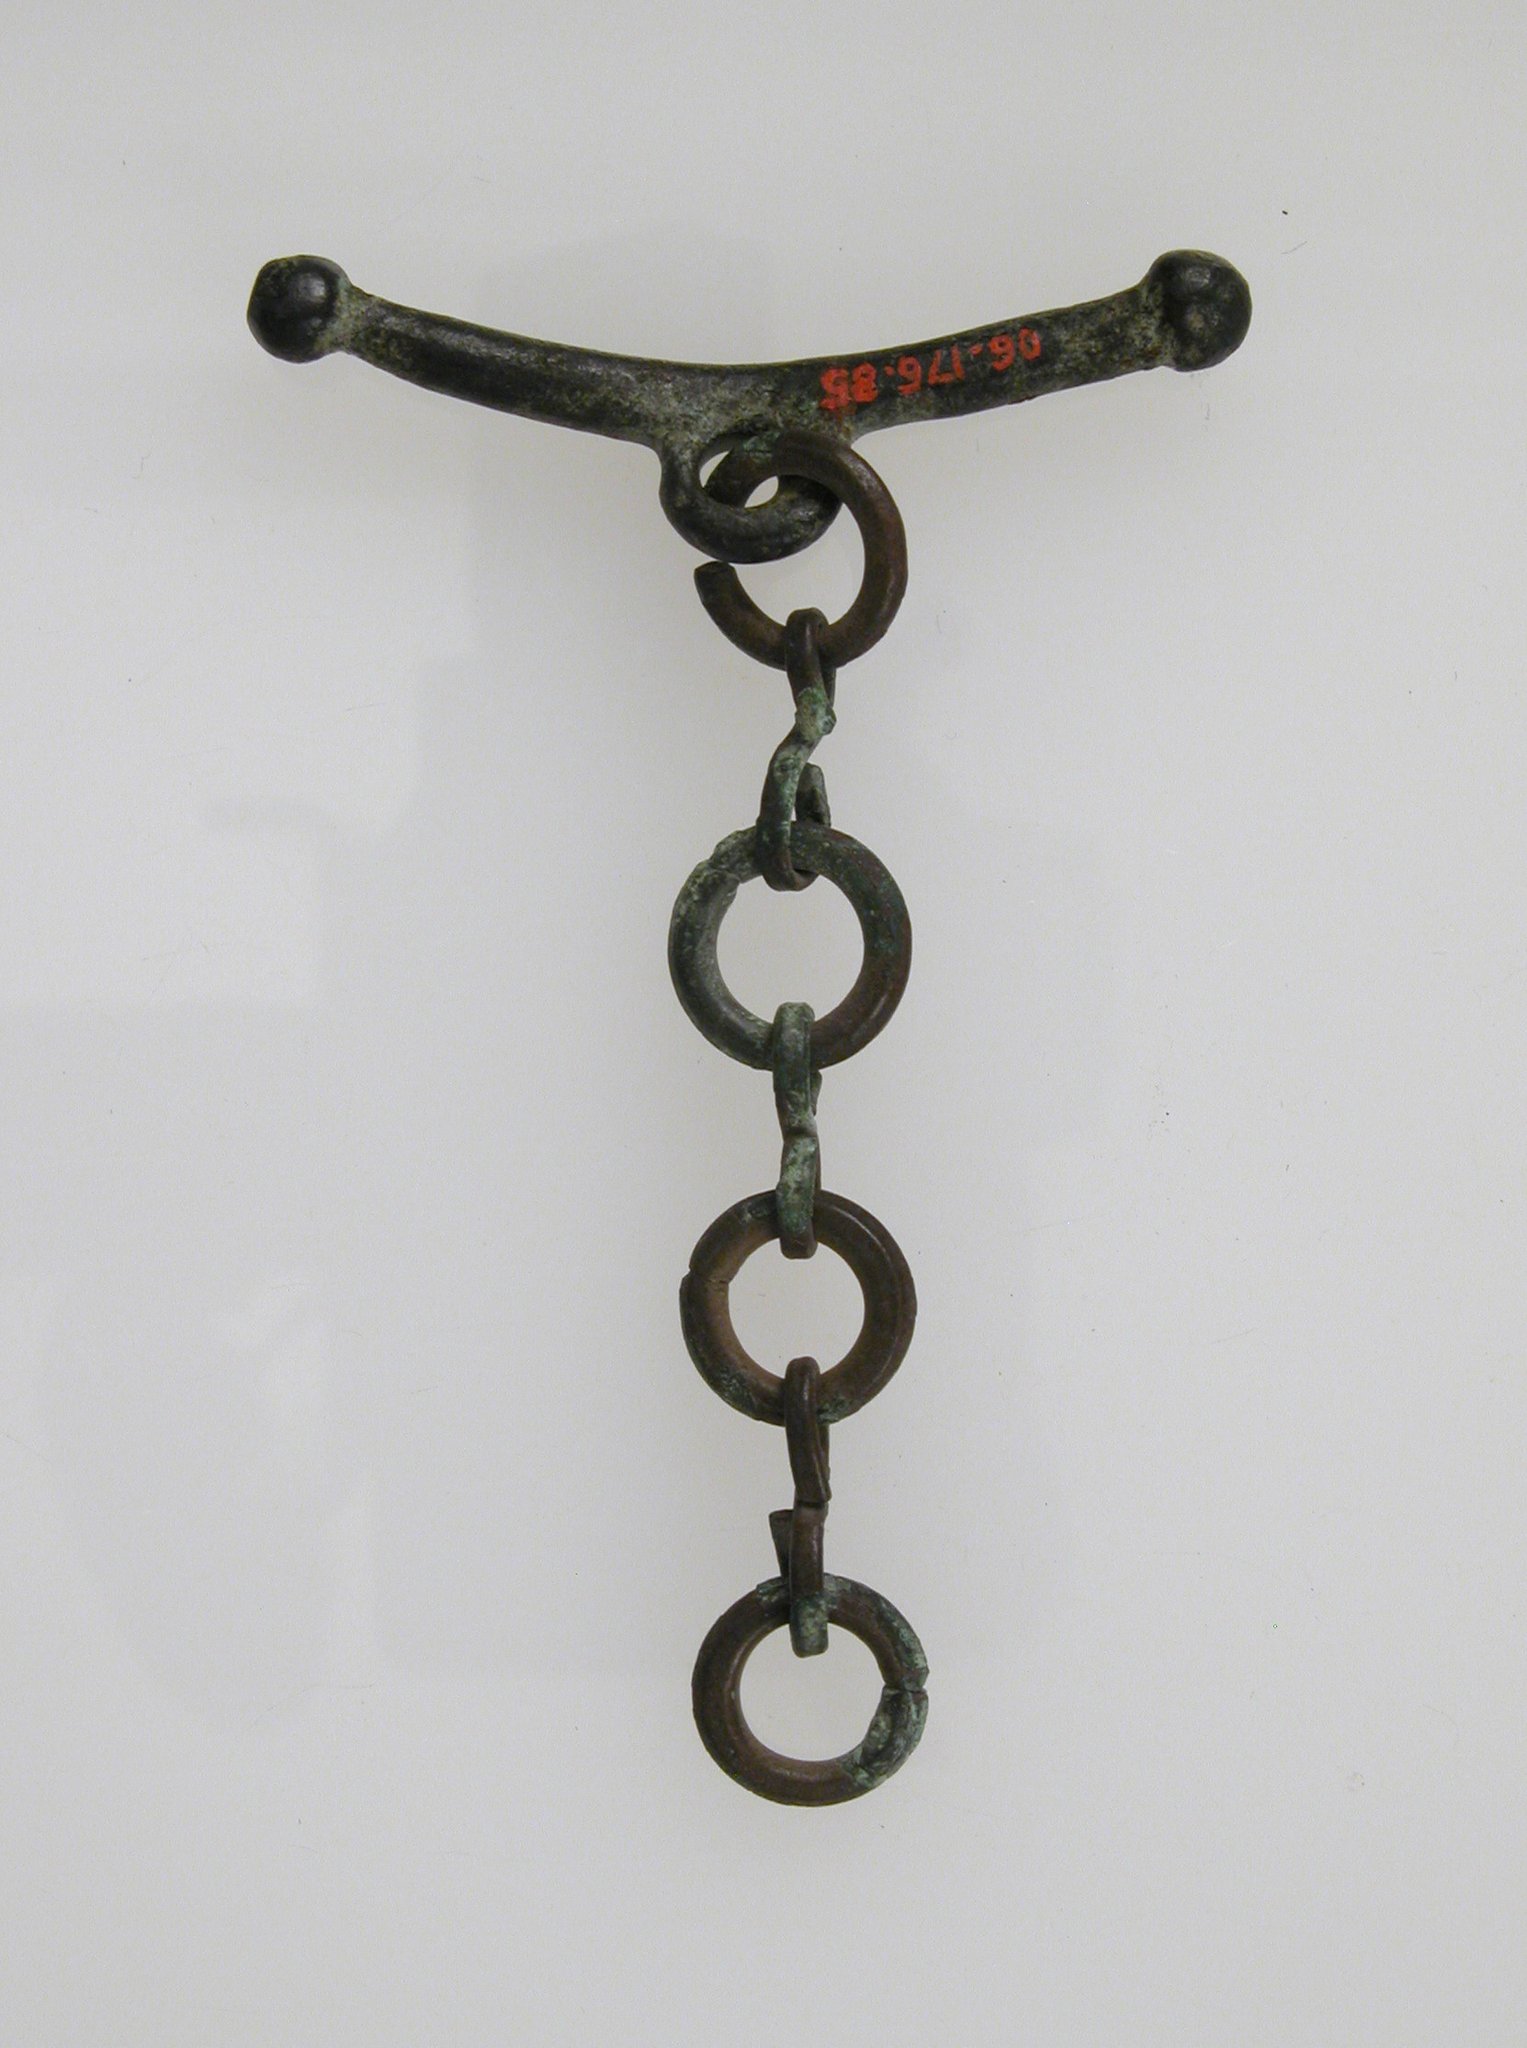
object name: chain fragment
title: Chain Fragment with Suspensory Bar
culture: roman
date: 1-700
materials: copper alloy